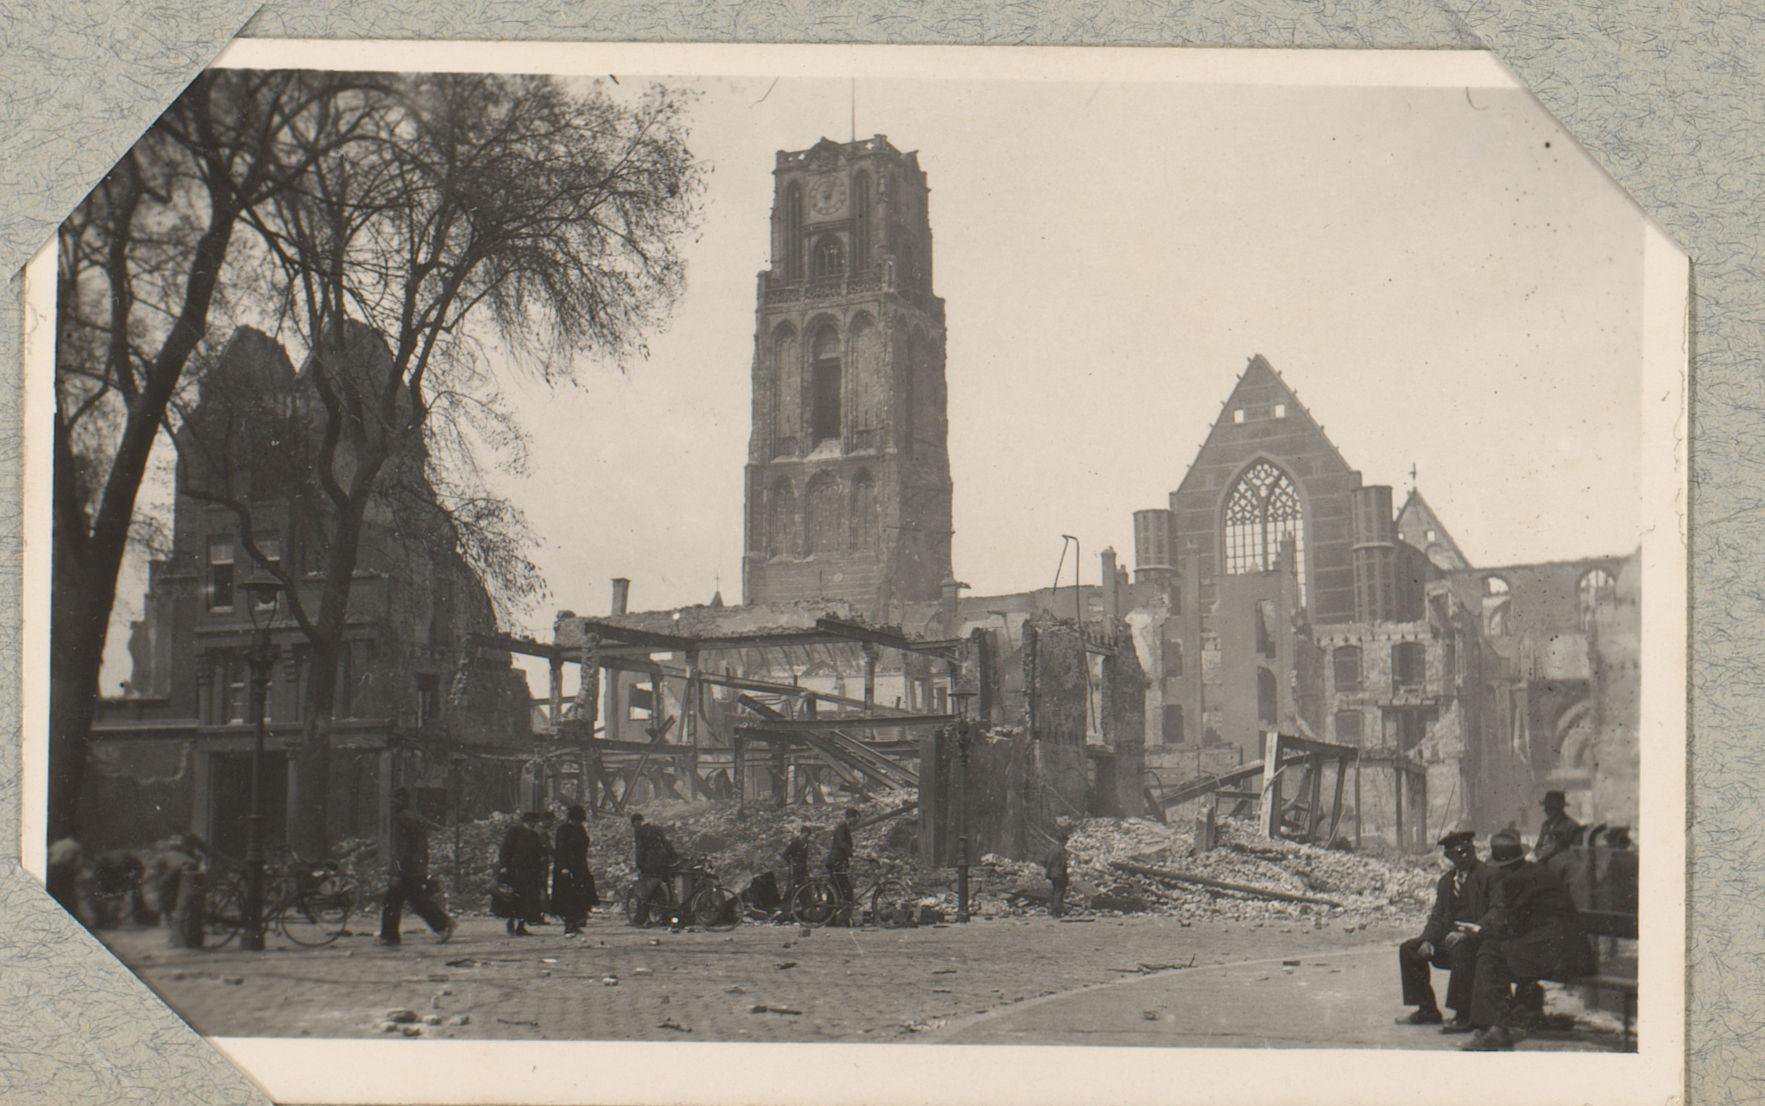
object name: photograph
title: Ruïnes rond de Grote of Sint-Laurenskerk te Rotterdam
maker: j. nolte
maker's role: fotograaf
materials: photographic support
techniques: gelatin silver print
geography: rotterdam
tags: ruin of church, monastery, etc. - qq - small church, chapel, devastated, ruined place or city (~ warfare), ruin of a dwelling, house, castle, etc., rotterdam, rotterdam blitz